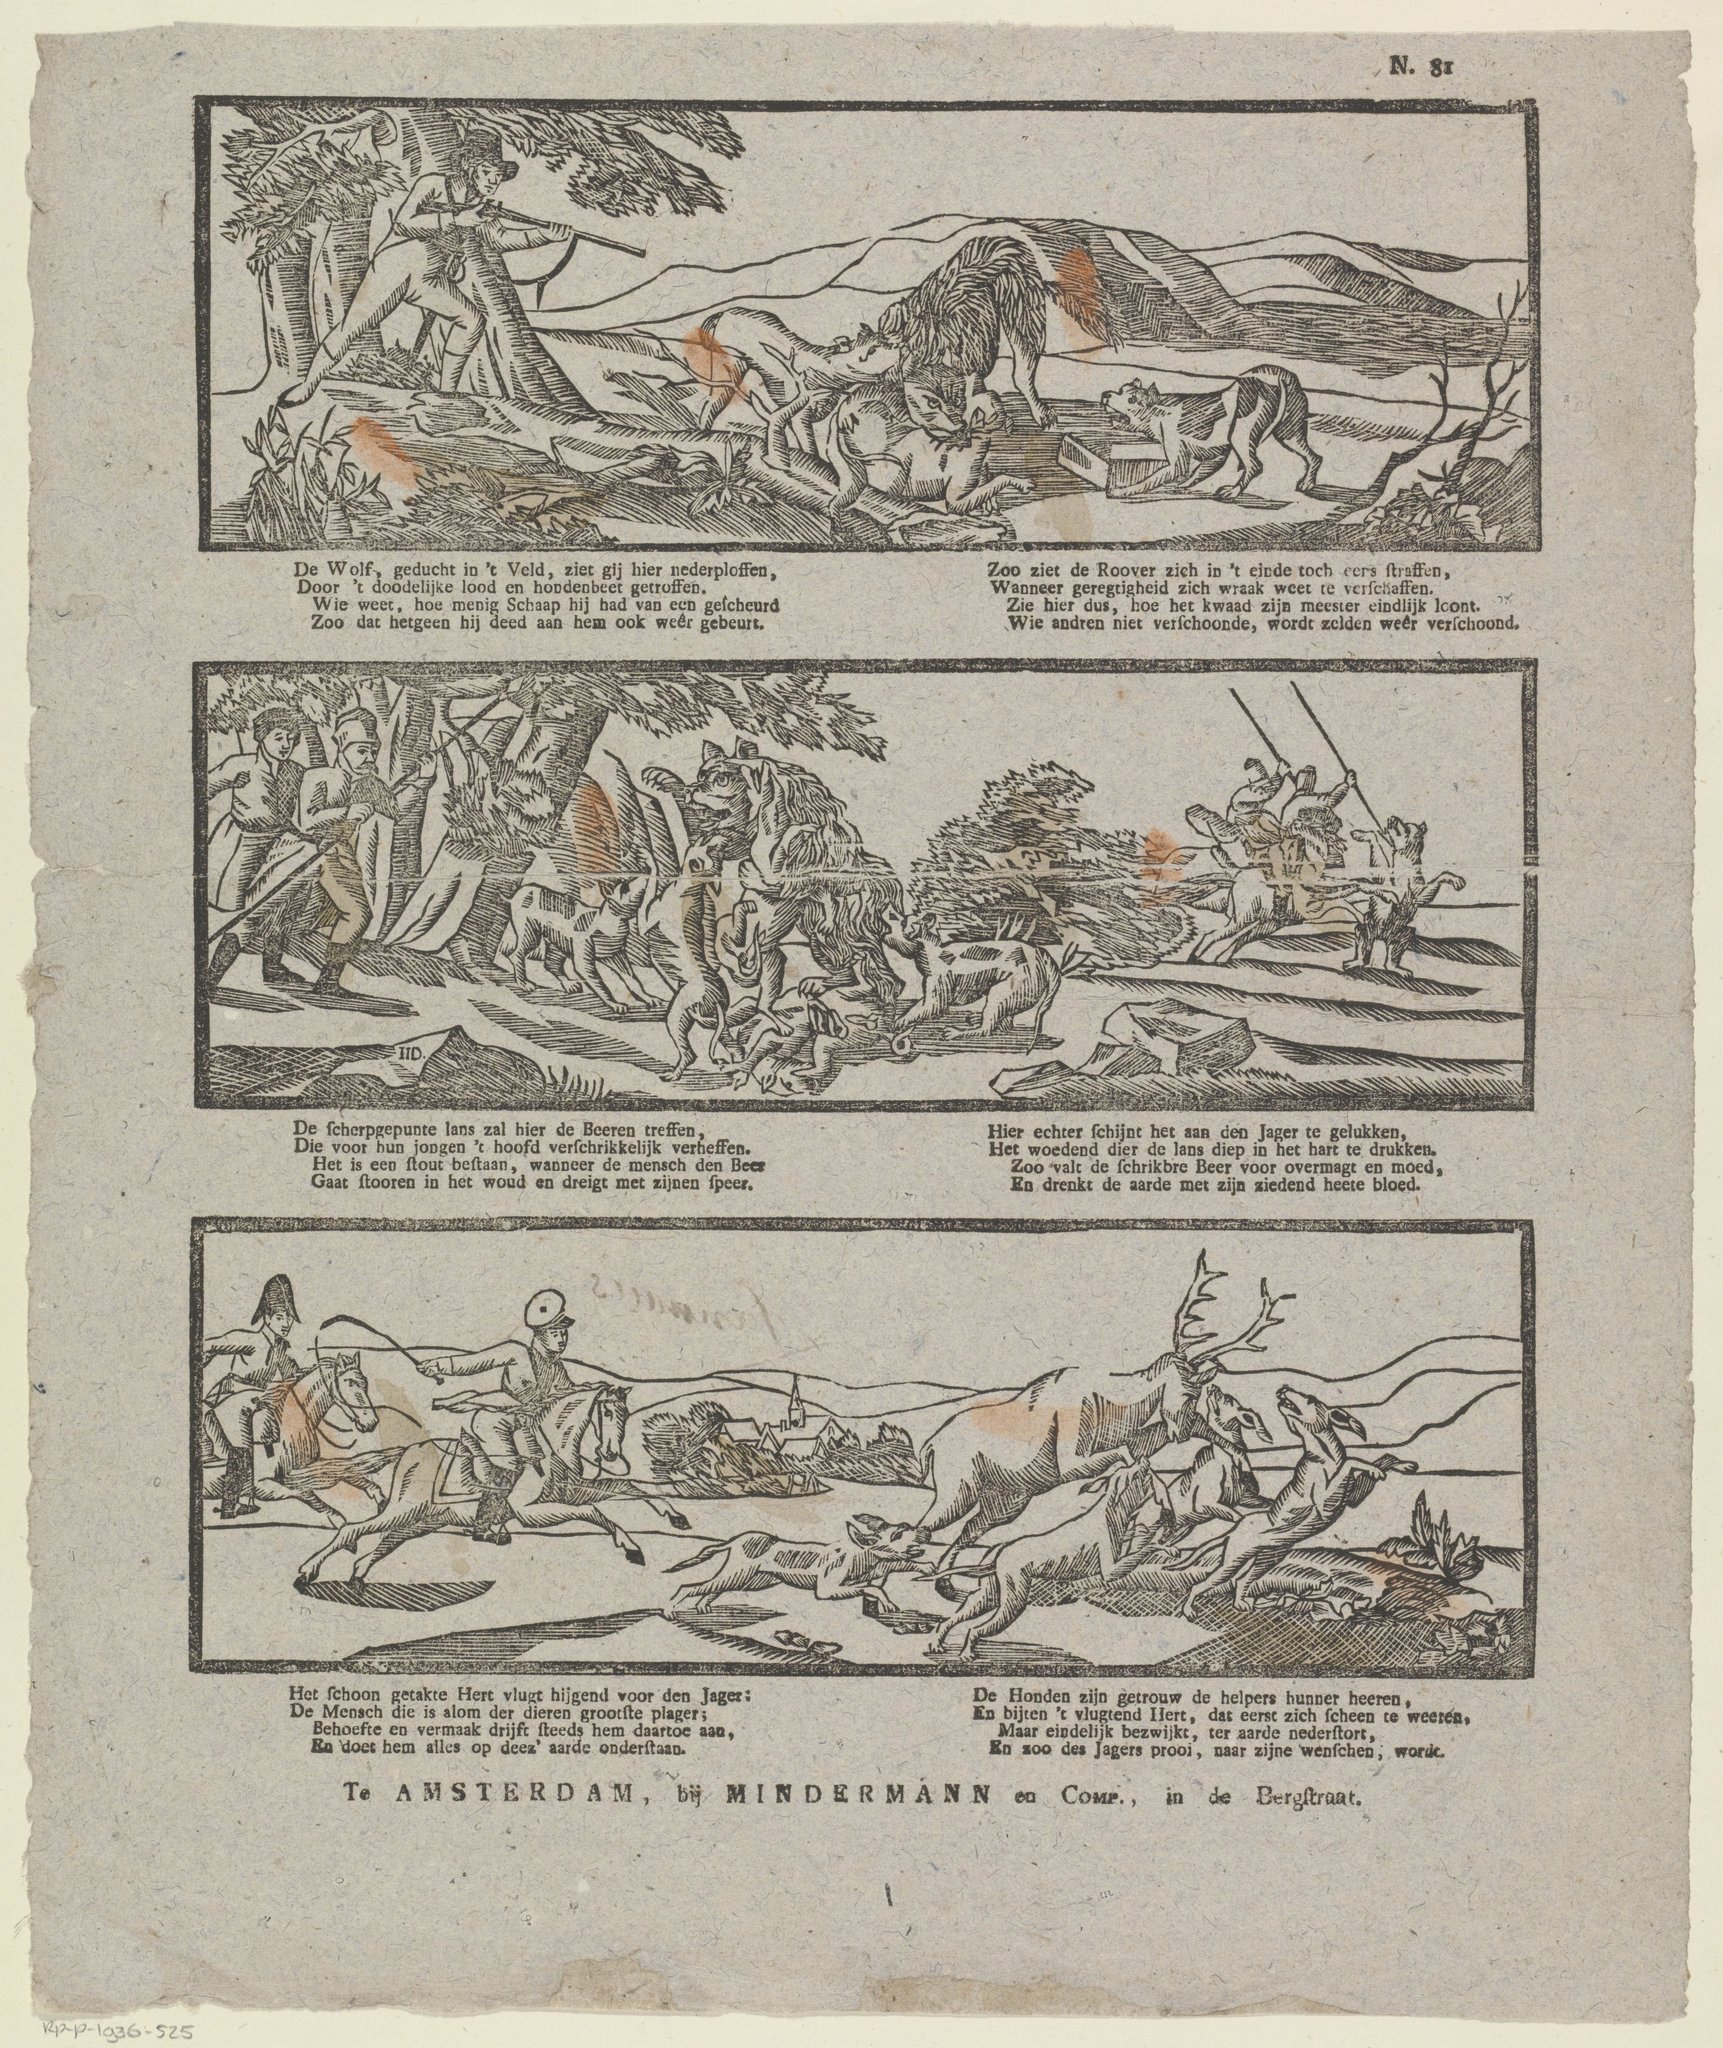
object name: print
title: Jachttaferelen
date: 1822-1849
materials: paper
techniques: colour, letterpress printing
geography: netherlands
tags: hunting dogs, hunter, hunters hunting (n.b.: in 1988-1990 this notation denoted the concept of 43c11421 'hunters resting during the hunt'), hunt ~ mammals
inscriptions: collector's mark: Lugt 2760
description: Blad met 3 voorstellingen van jachttaferelen. Onder elke afbeelding een achtregelig vers in twee kolommen. Genummerd rechtsboven: N. 81.